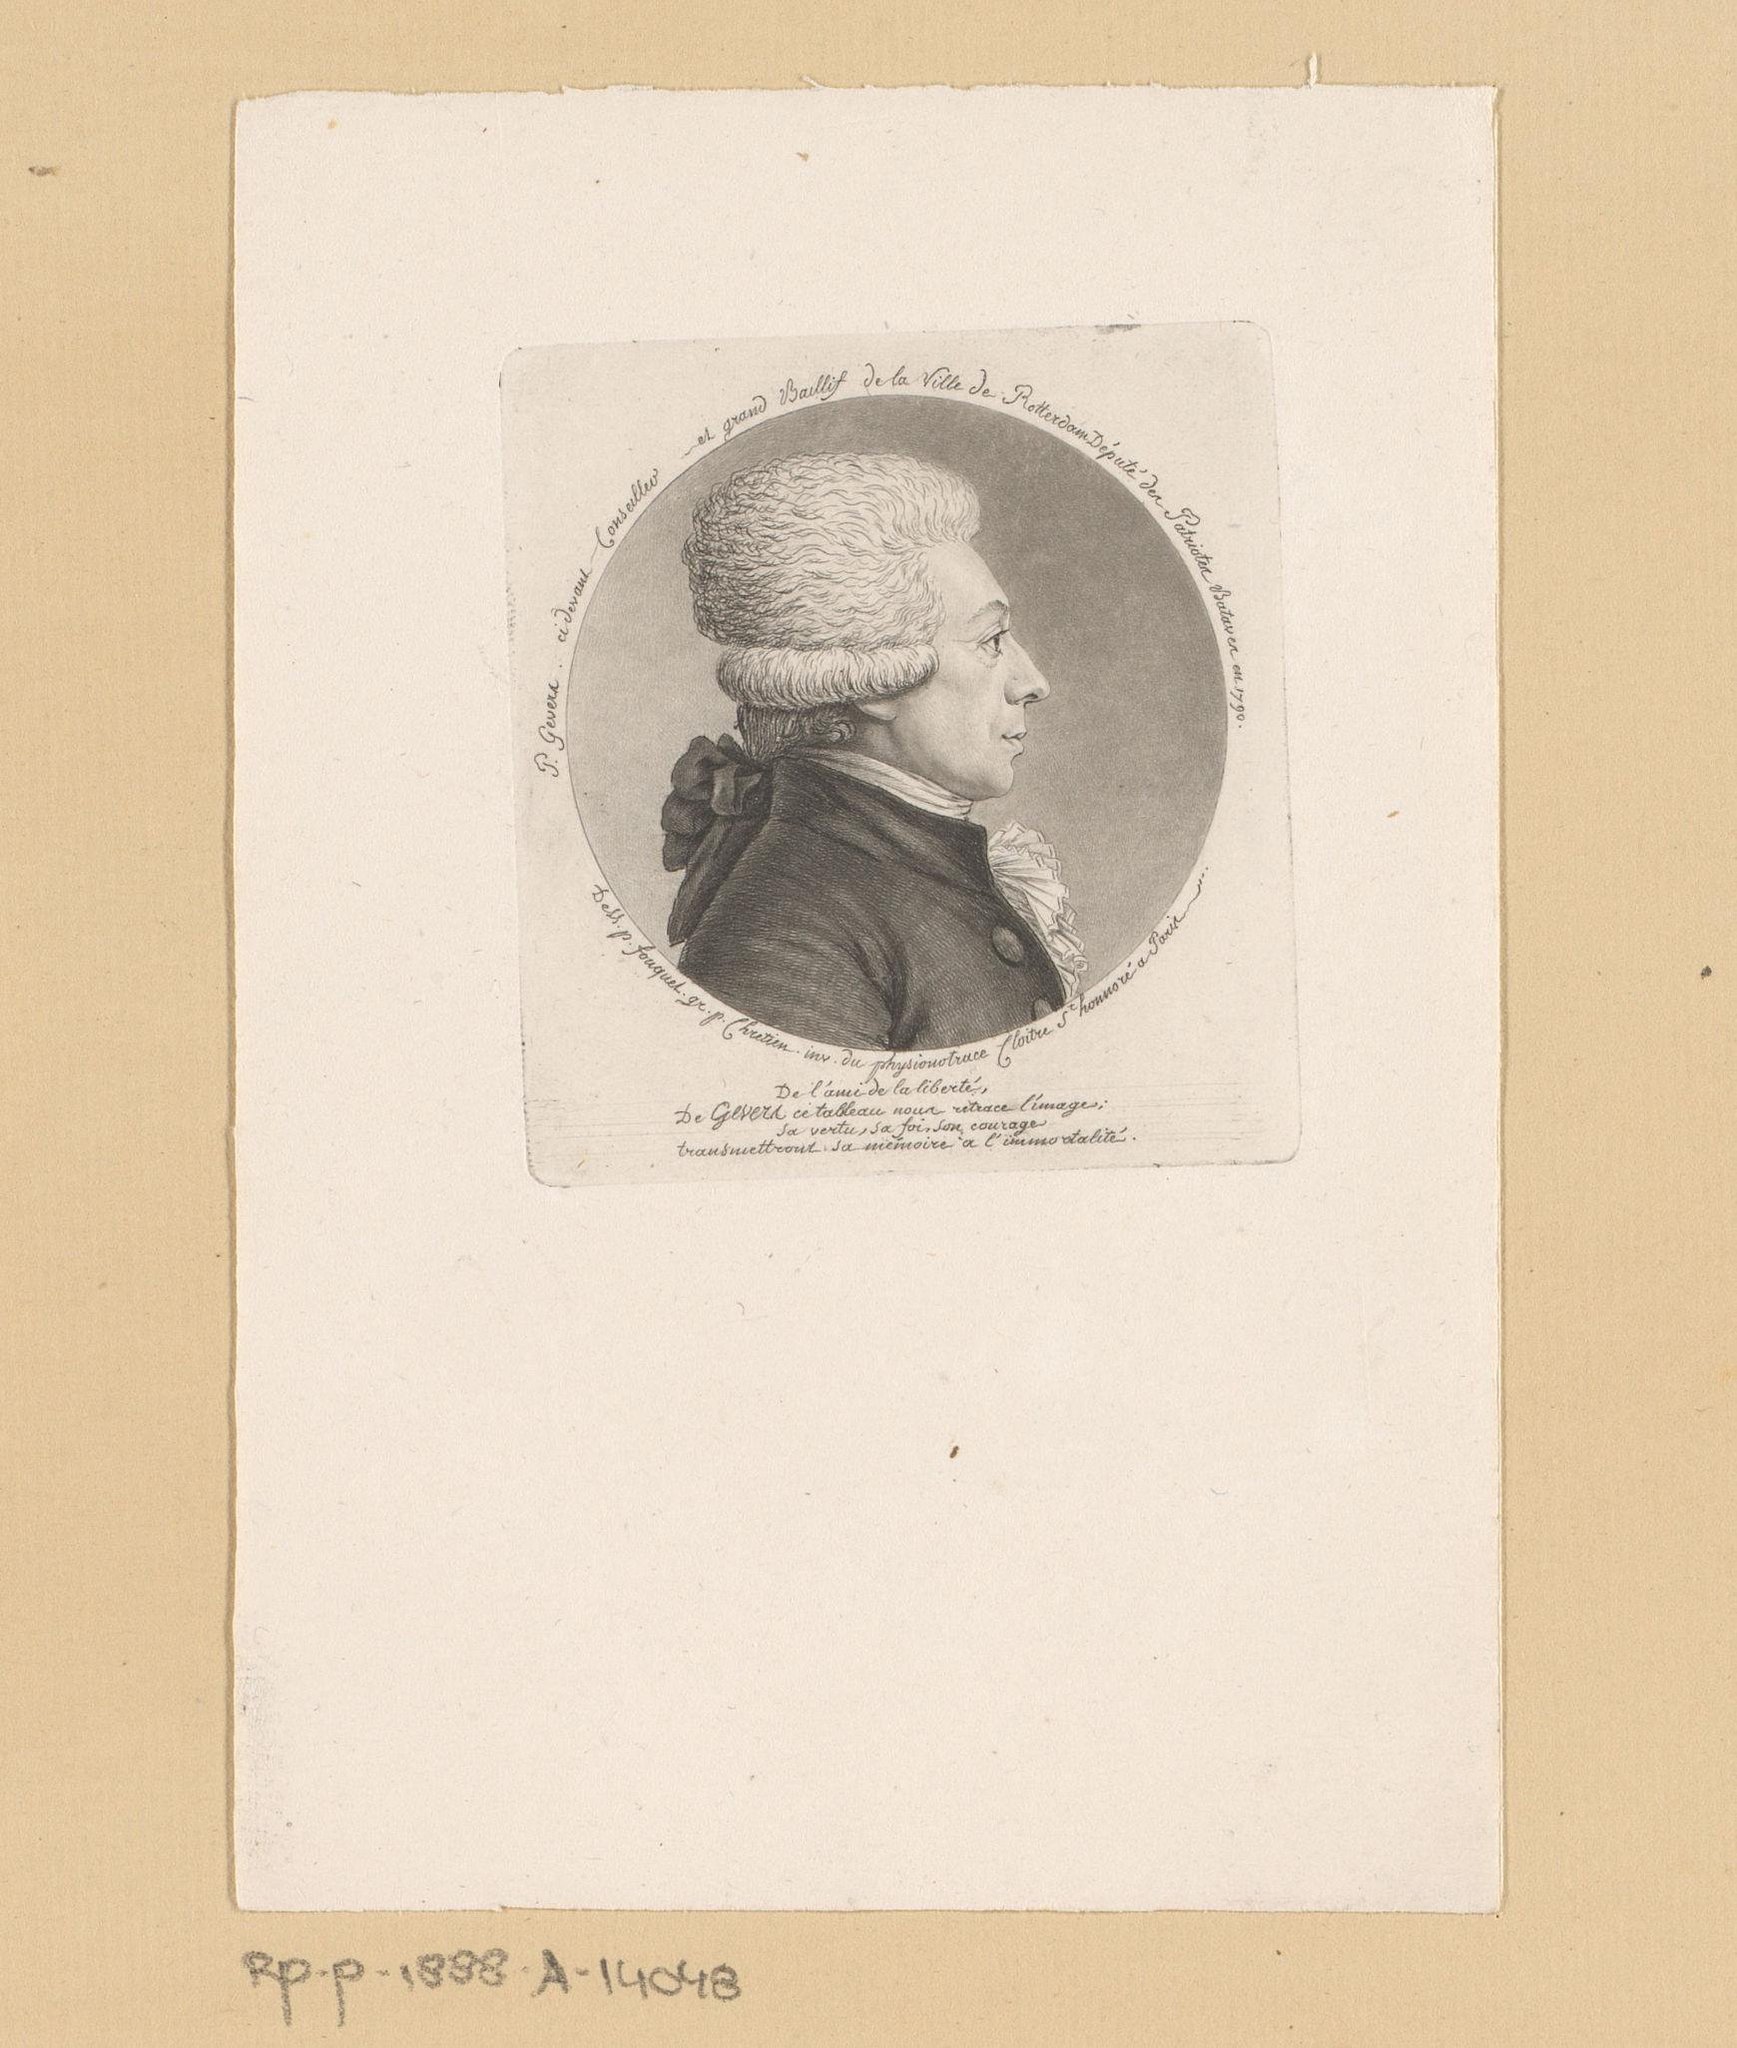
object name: physionotrace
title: Portret van Paulus Gevers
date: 1790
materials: paper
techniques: aquatint, etching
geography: paris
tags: rotterdam, silhouette-apparatus, 'physionotrace', historical persons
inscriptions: collector's mark: Lugt 2227